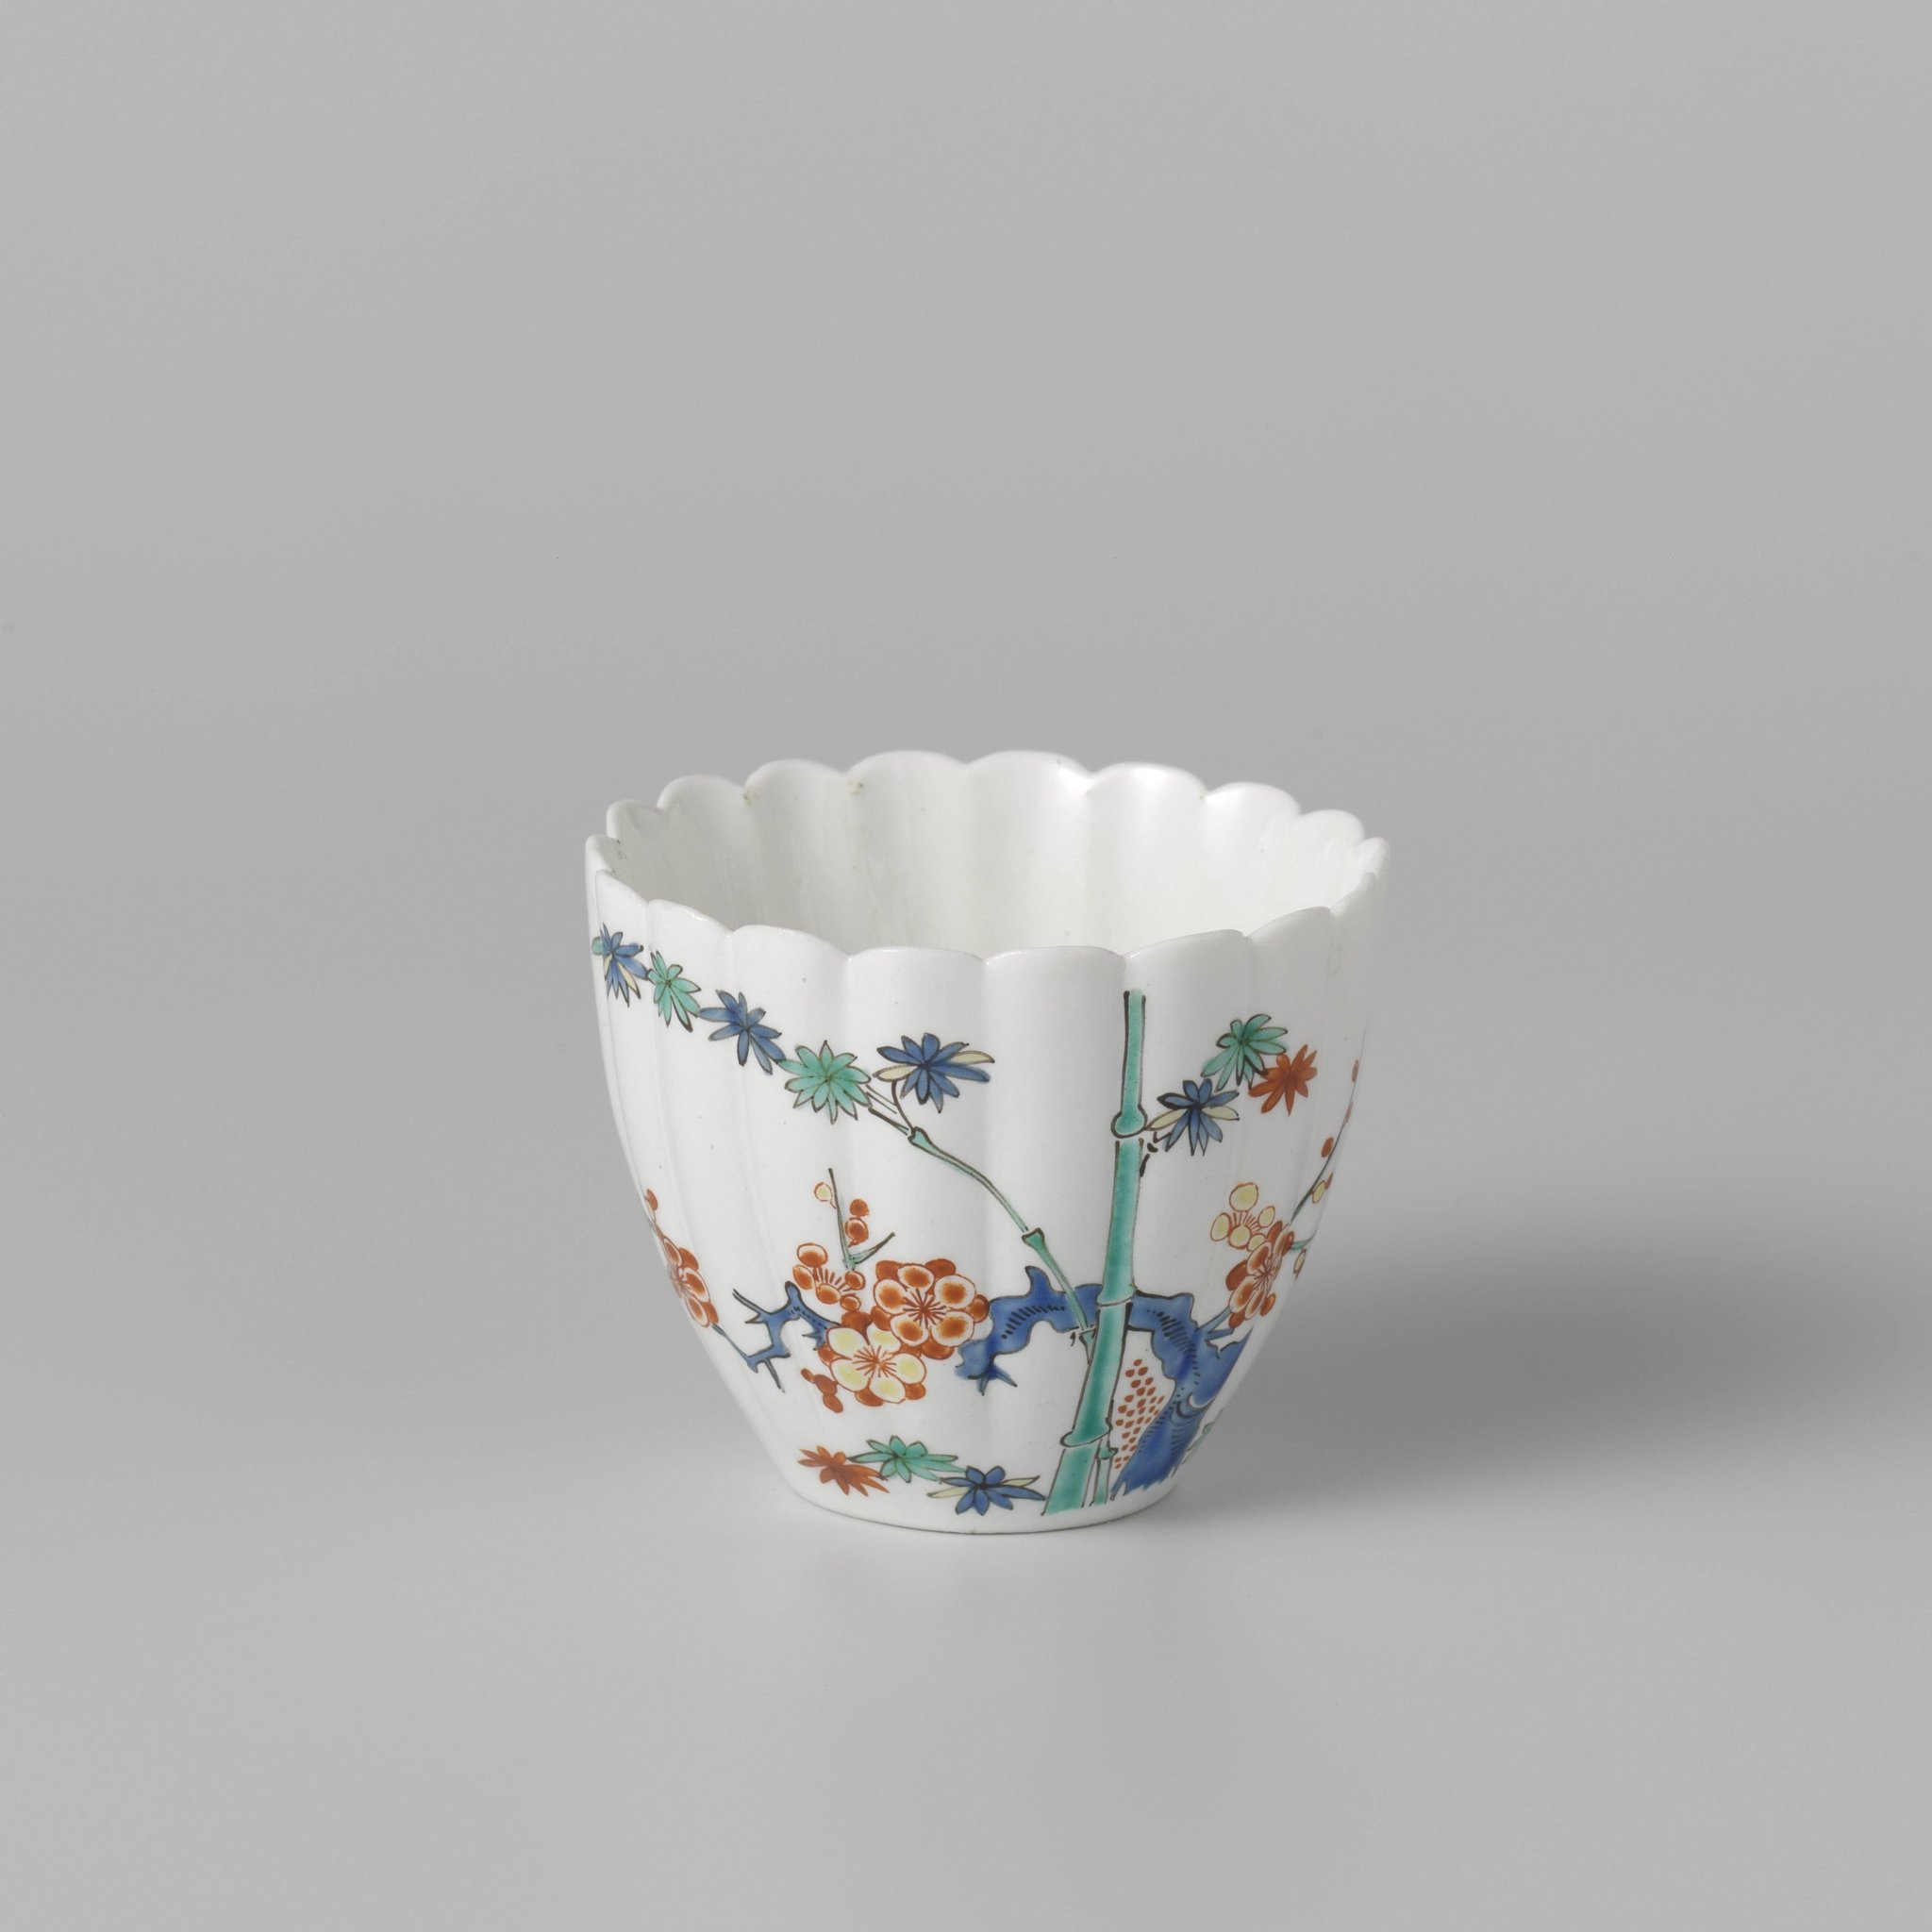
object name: cup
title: Cup with birds and flowering plants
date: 1730-1750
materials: glaze, paint, porcelain, soft paste porcelain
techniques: firing, forming, turning, vitrification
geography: chantilly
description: Cup, soft paste porcelain Chantilly, c. 1730 - 1750